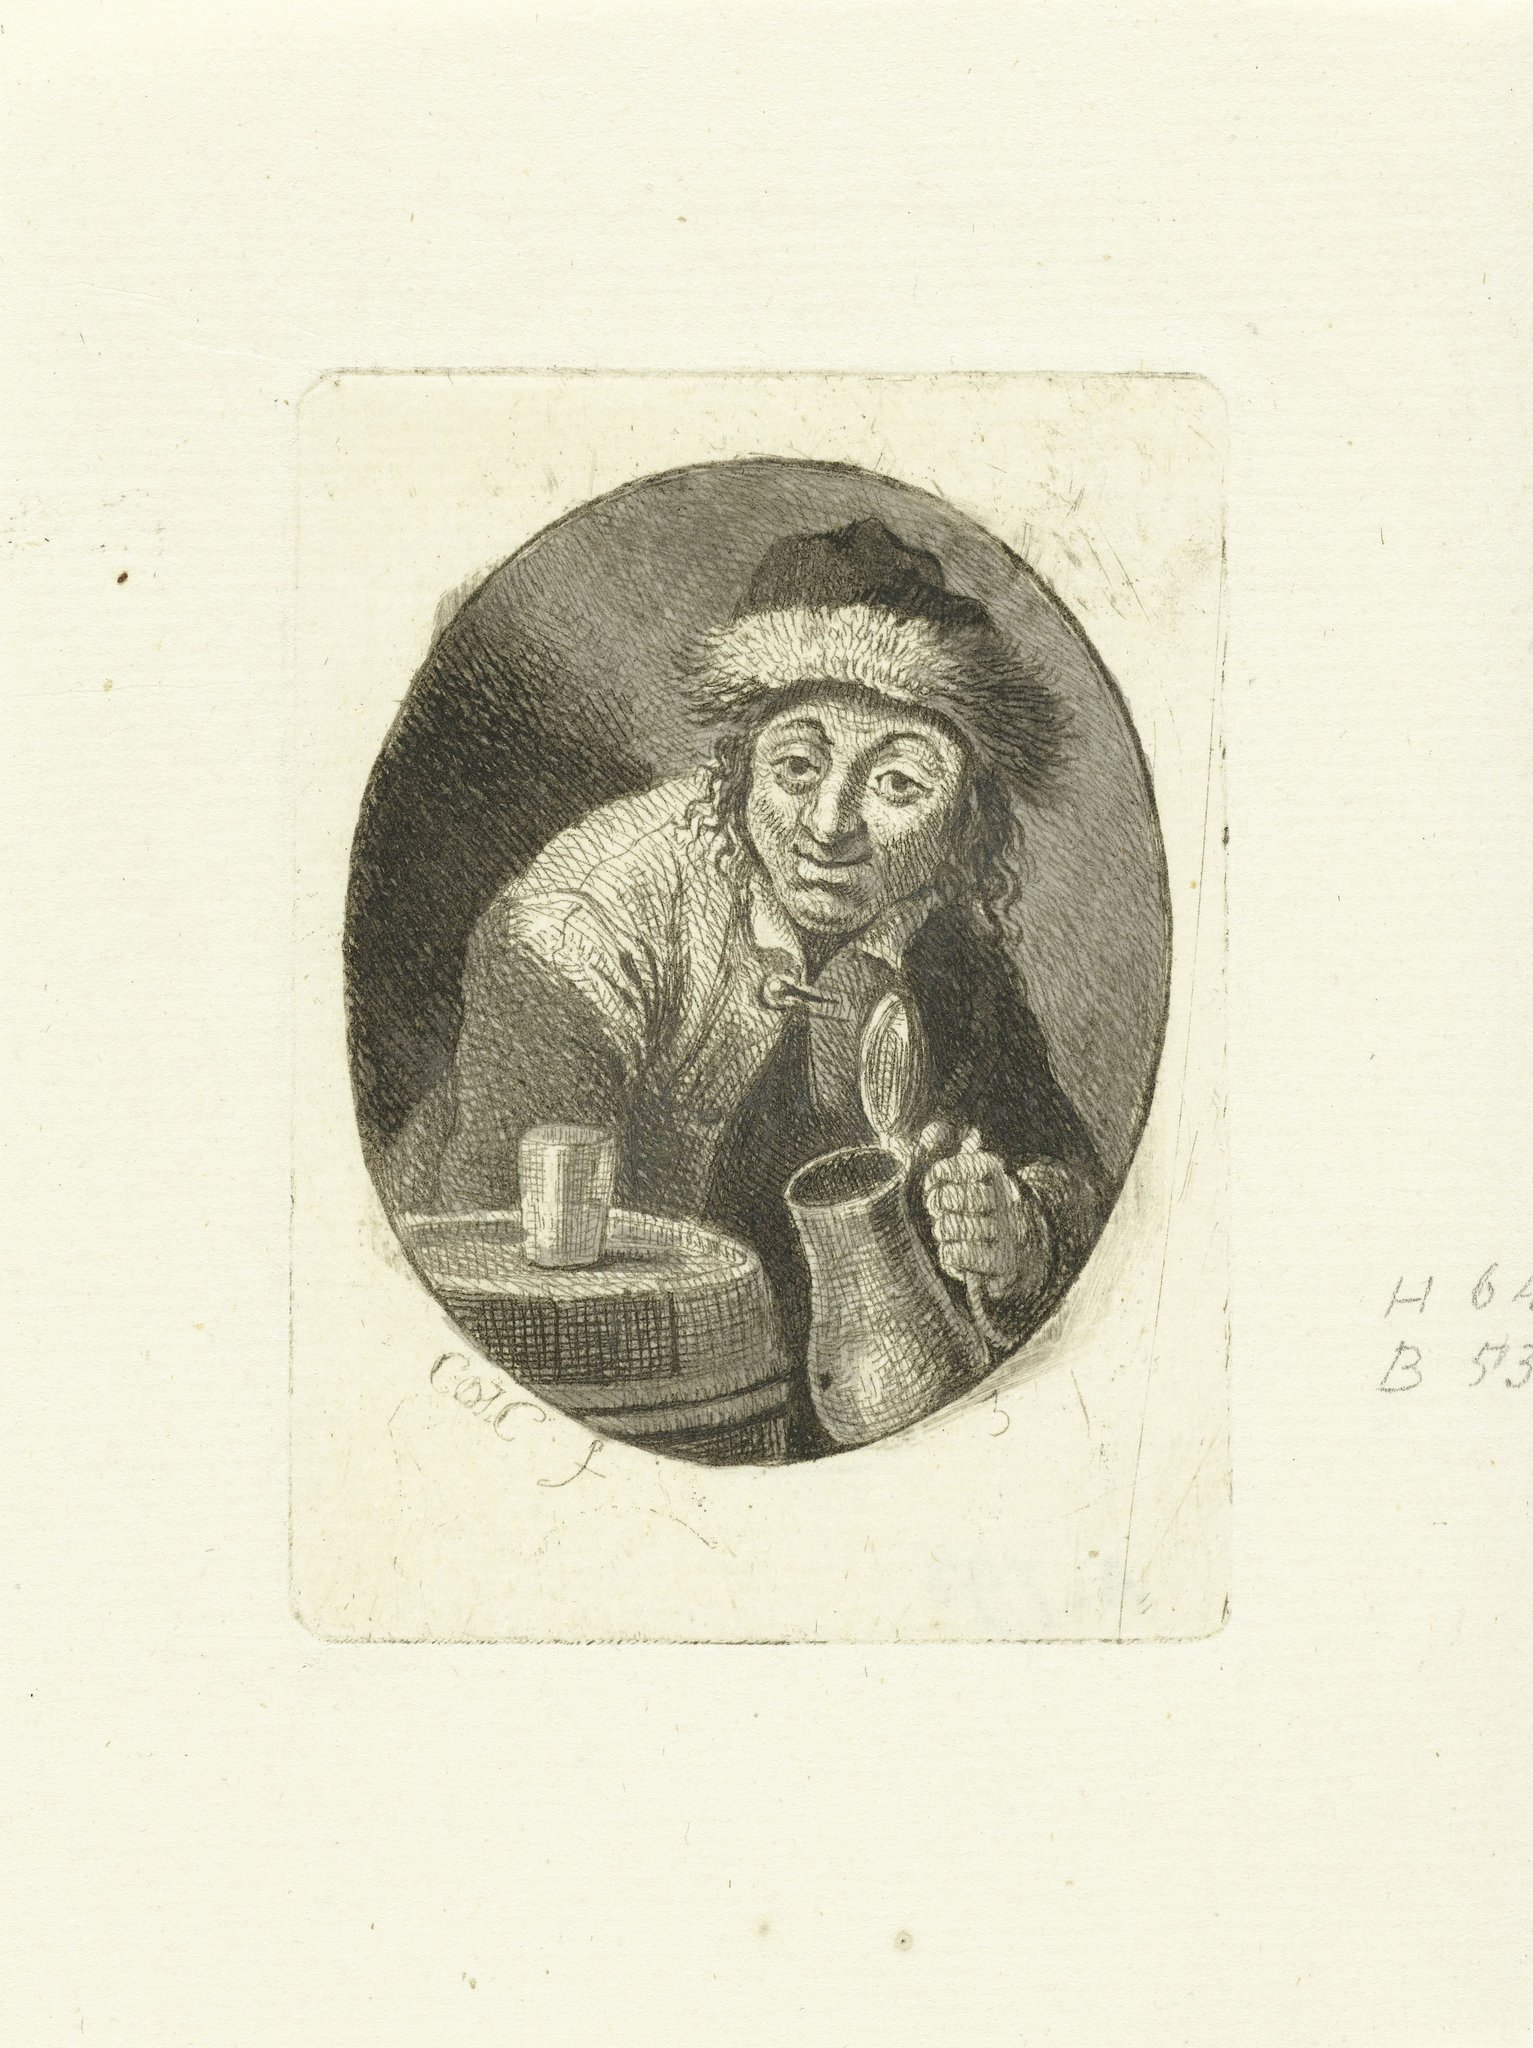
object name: print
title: Man met schenkkan en glas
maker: johannes van cuylenburgh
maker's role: print maker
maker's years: 1793-1841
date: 1768-1827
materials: paper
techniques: etching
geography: netherlands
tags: drinking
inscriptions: collector's mark: Lugt 2228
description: Prent maakt mogelijk deel uit van serie want het blad is genummerd.